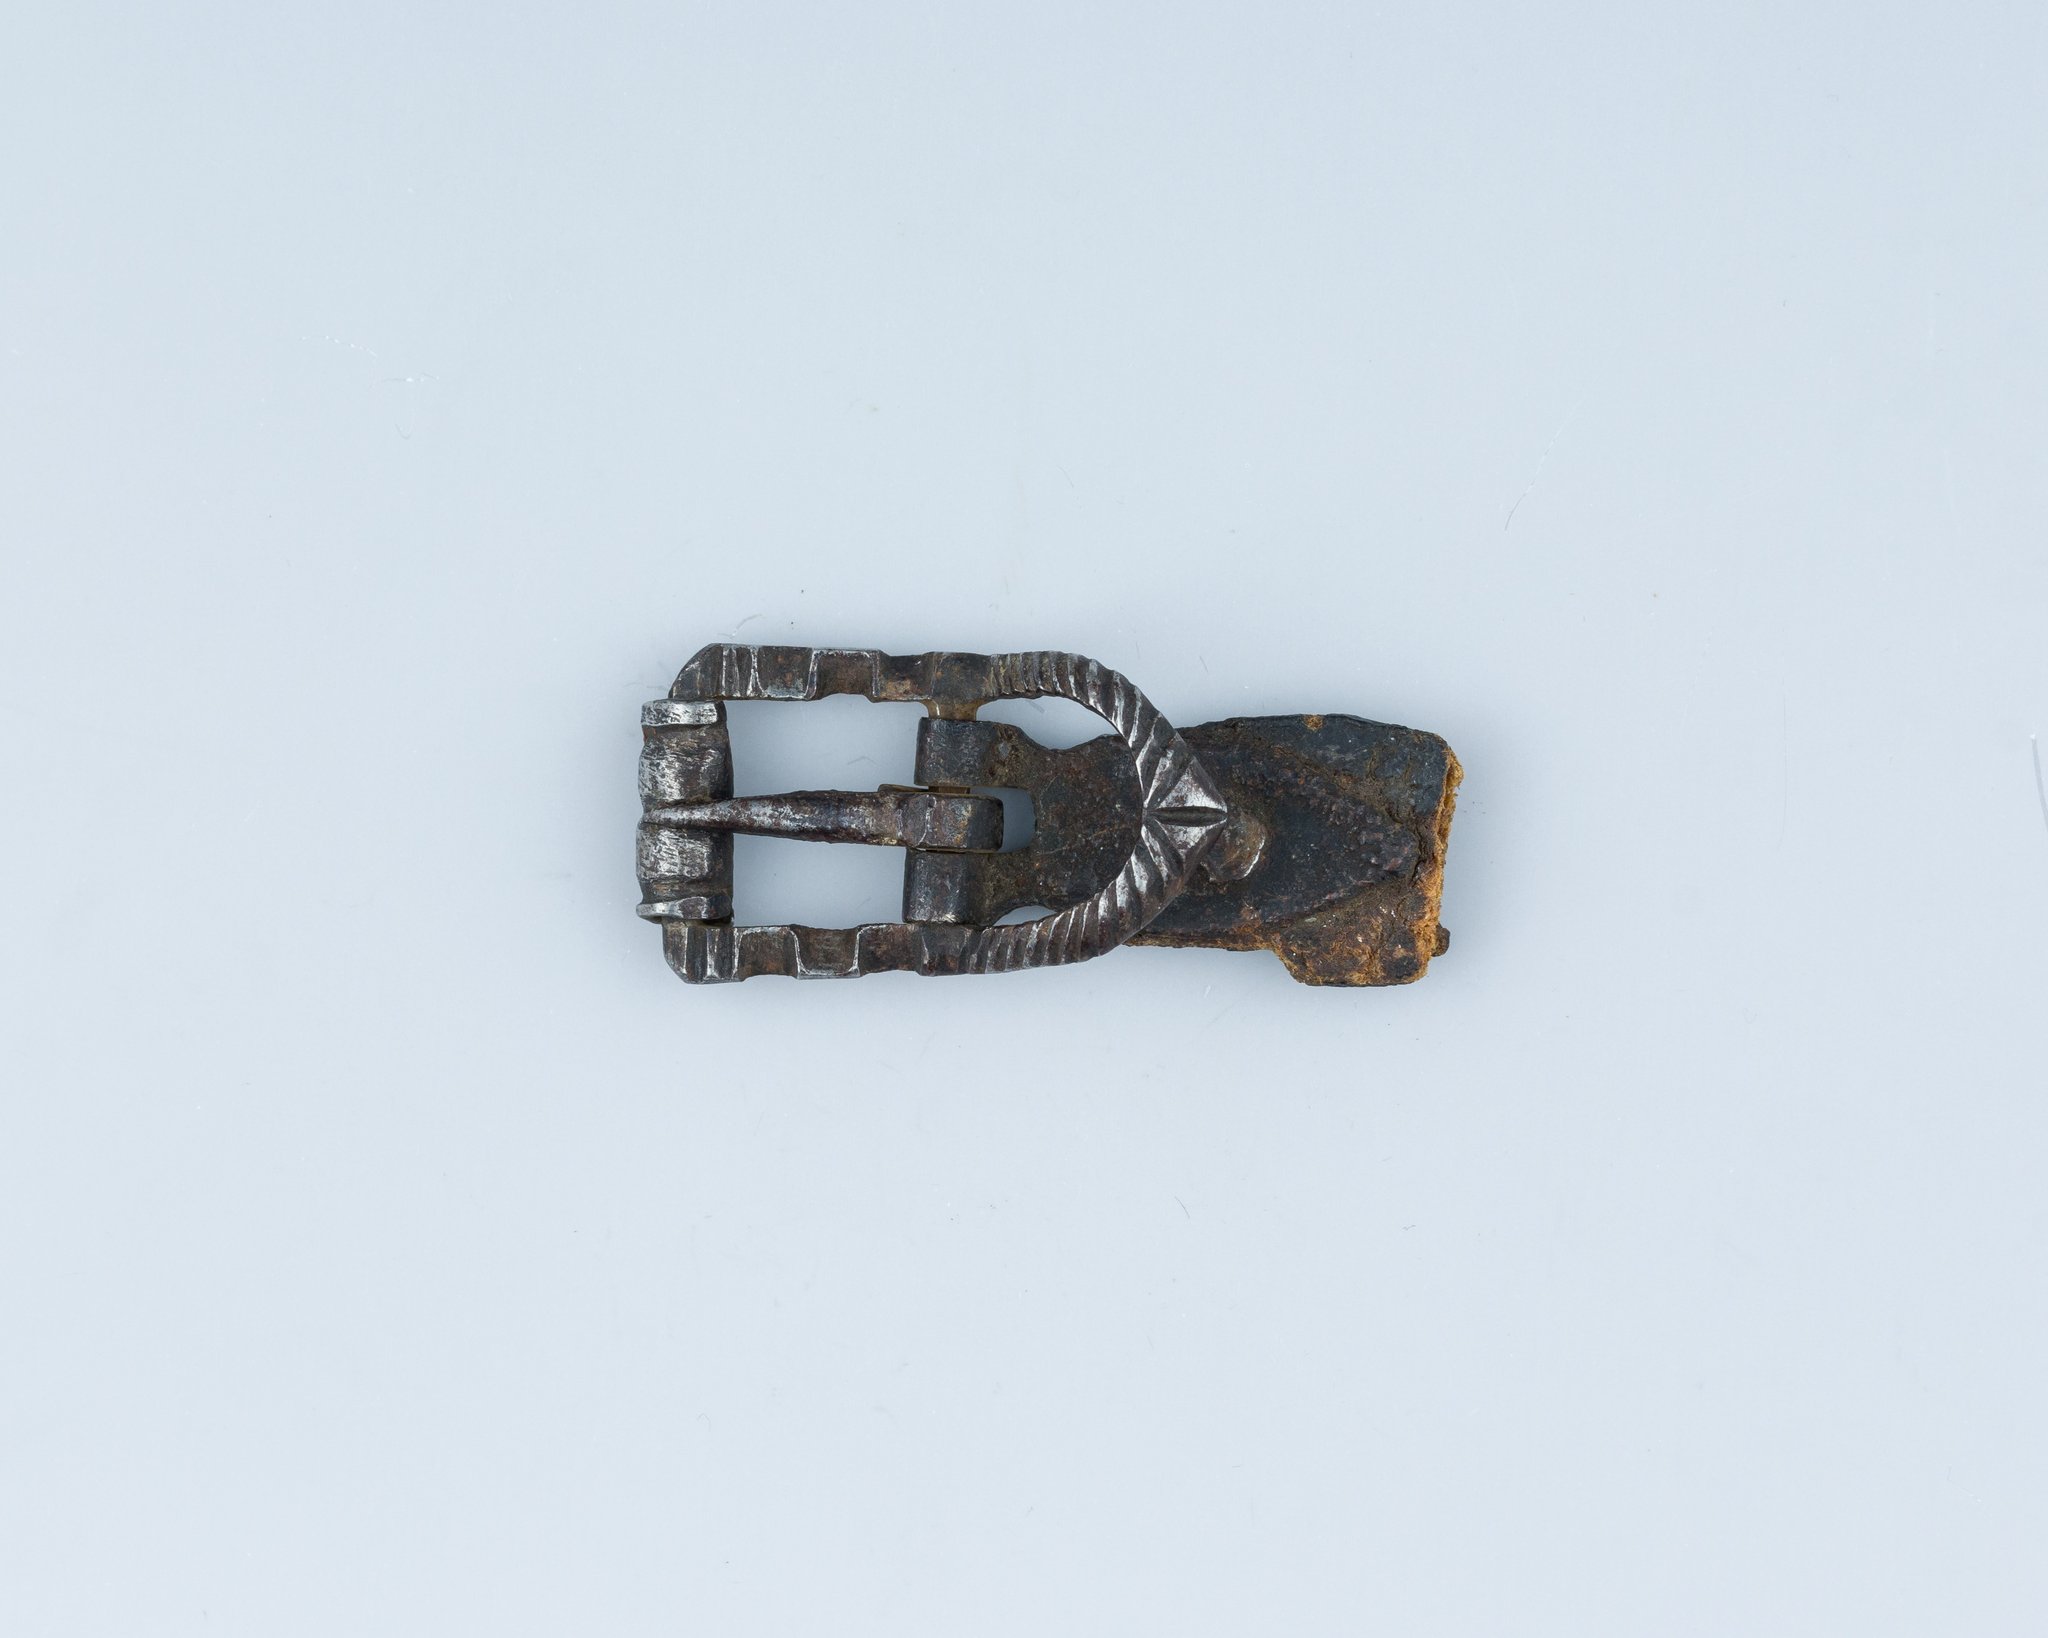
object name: buckle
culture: german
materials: steel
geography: germany